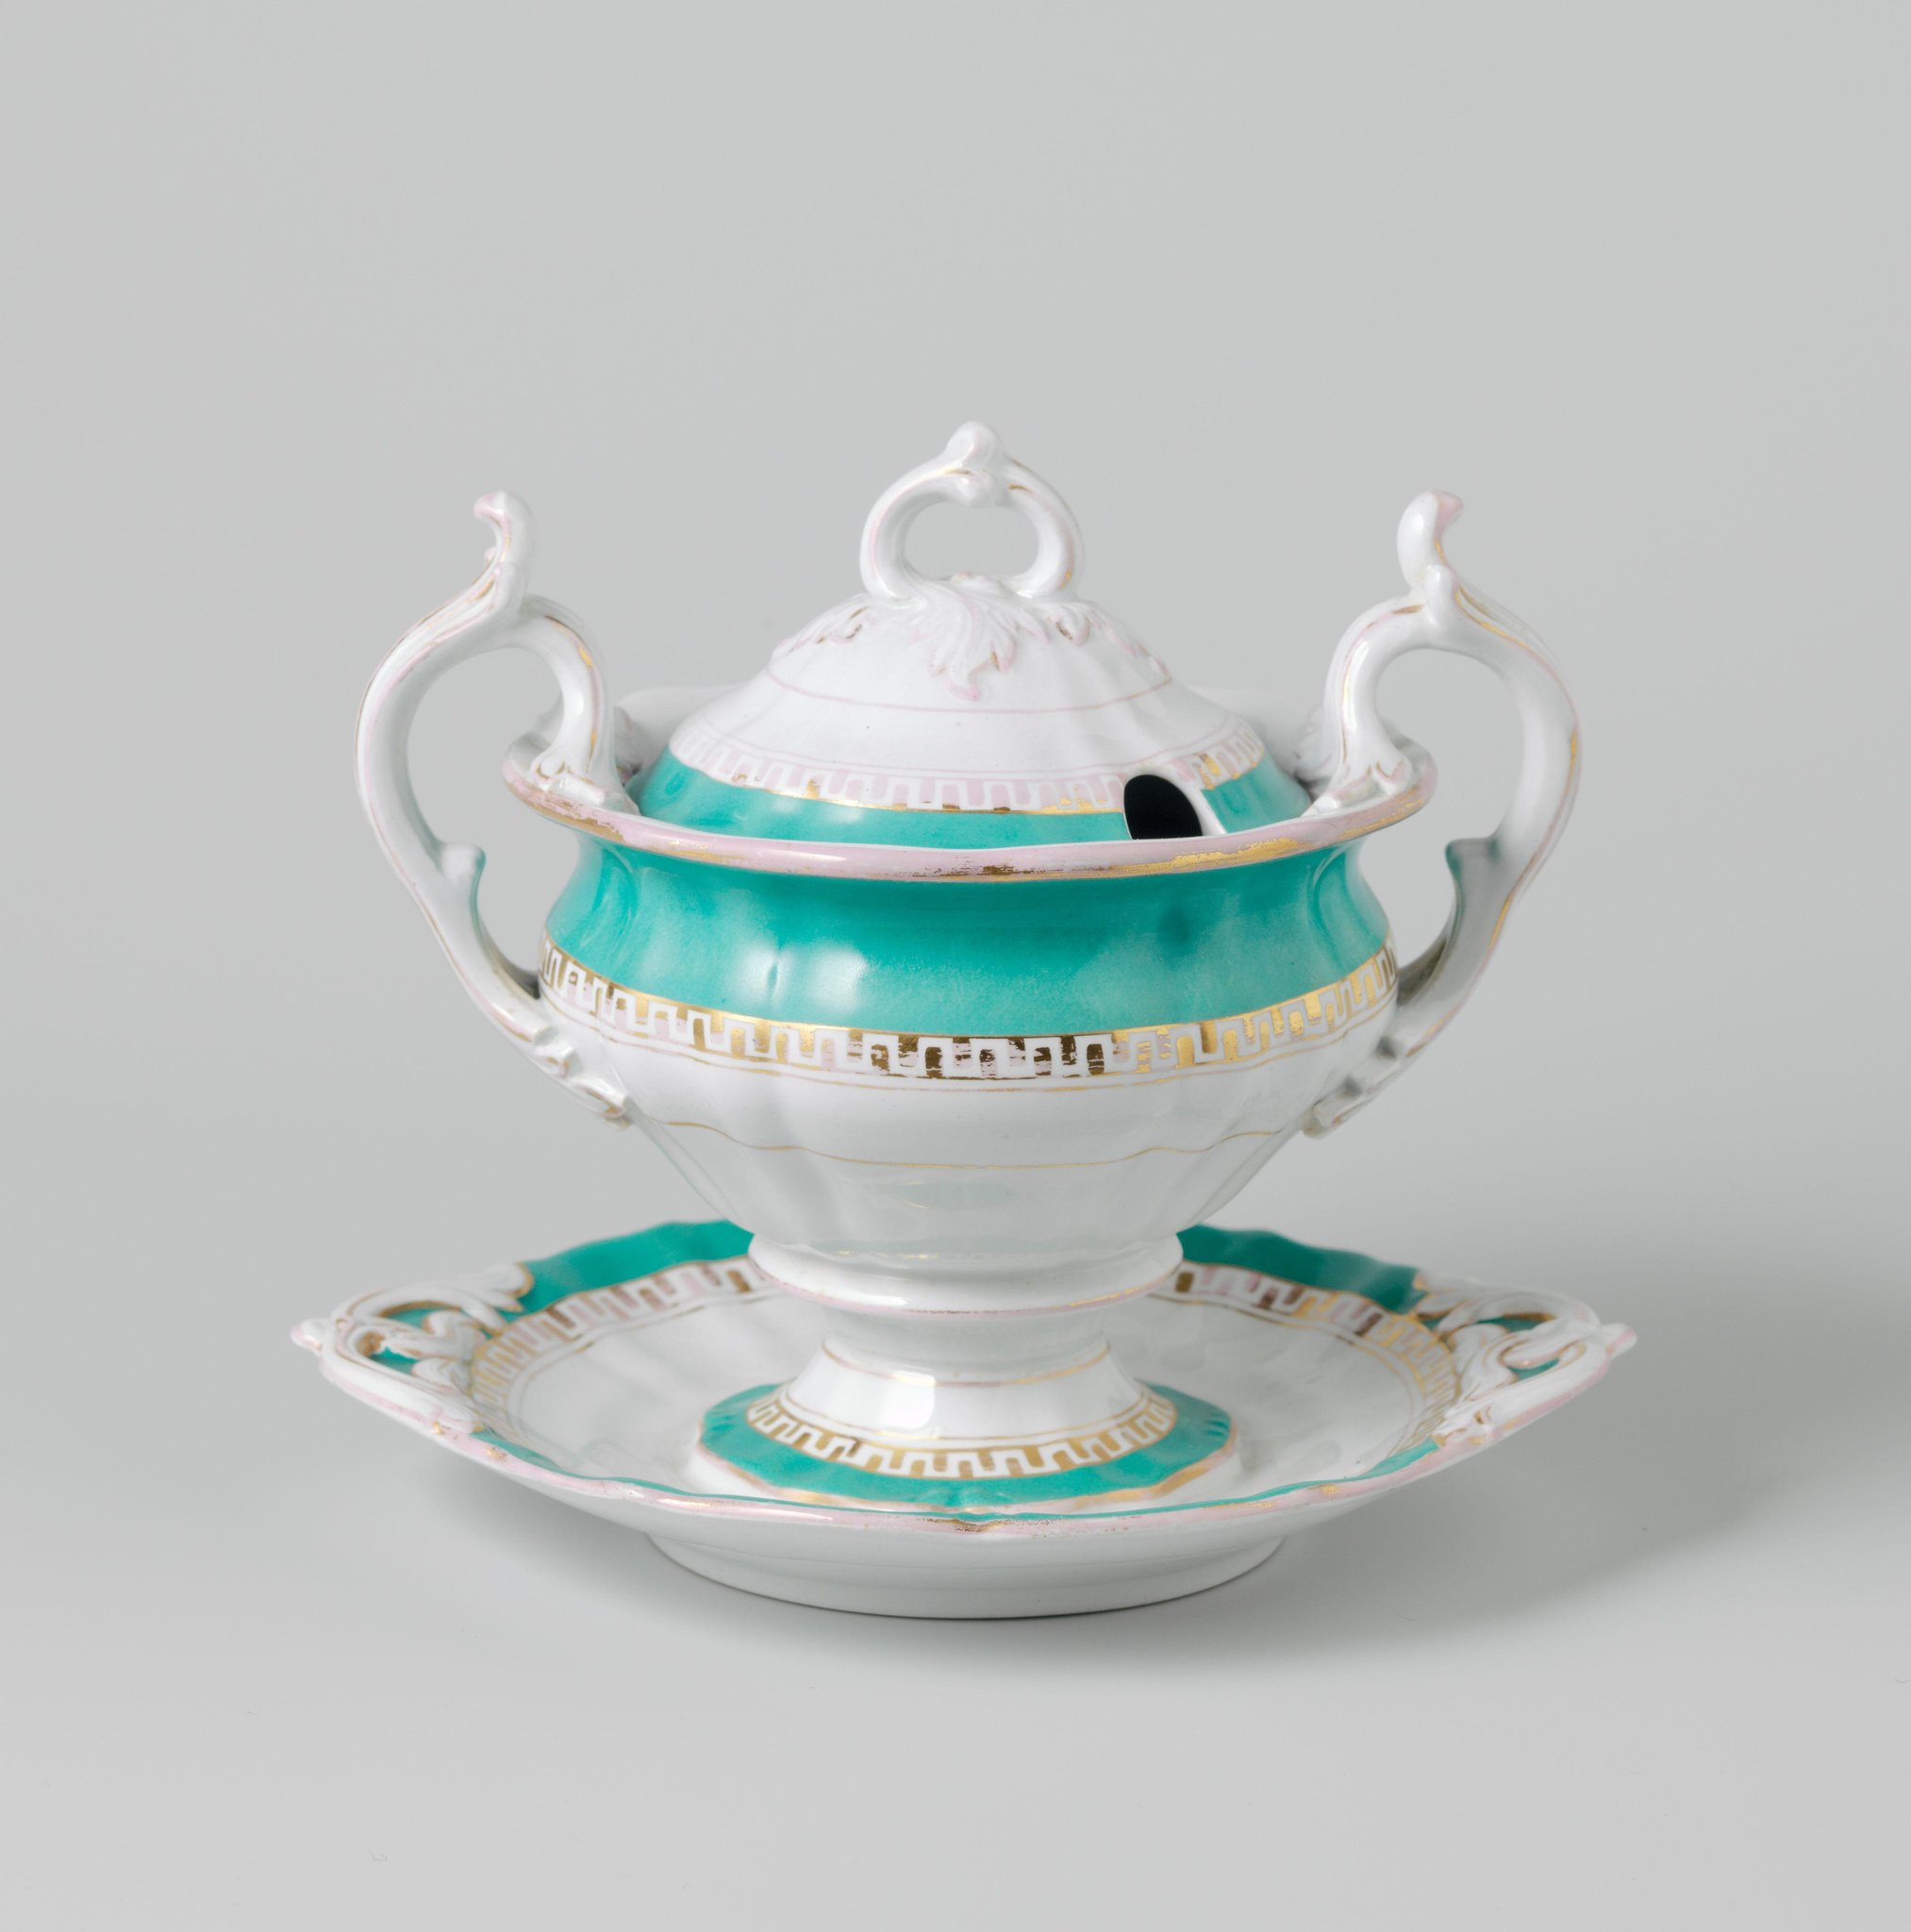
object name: tureen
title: Deksel, op vaste onderschotel, met groene rand en gouden Griekse band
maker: petrus regout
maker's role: plateelbakker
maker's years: 1801-1879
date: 1865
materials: earthenware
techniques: transfer decoration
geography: maastricht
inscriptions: check stamp: ‘P. REGOUT // MAASTRICHT // 2X 1’, check stamp: ‘1’, mark: ‘P. REGOUT HOLLAND MAASTRICHT’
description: Deksel van aardewerk, rond, geschulpt, met groene rand en gouden Griekse band. De knop in de vorm van bladranken.